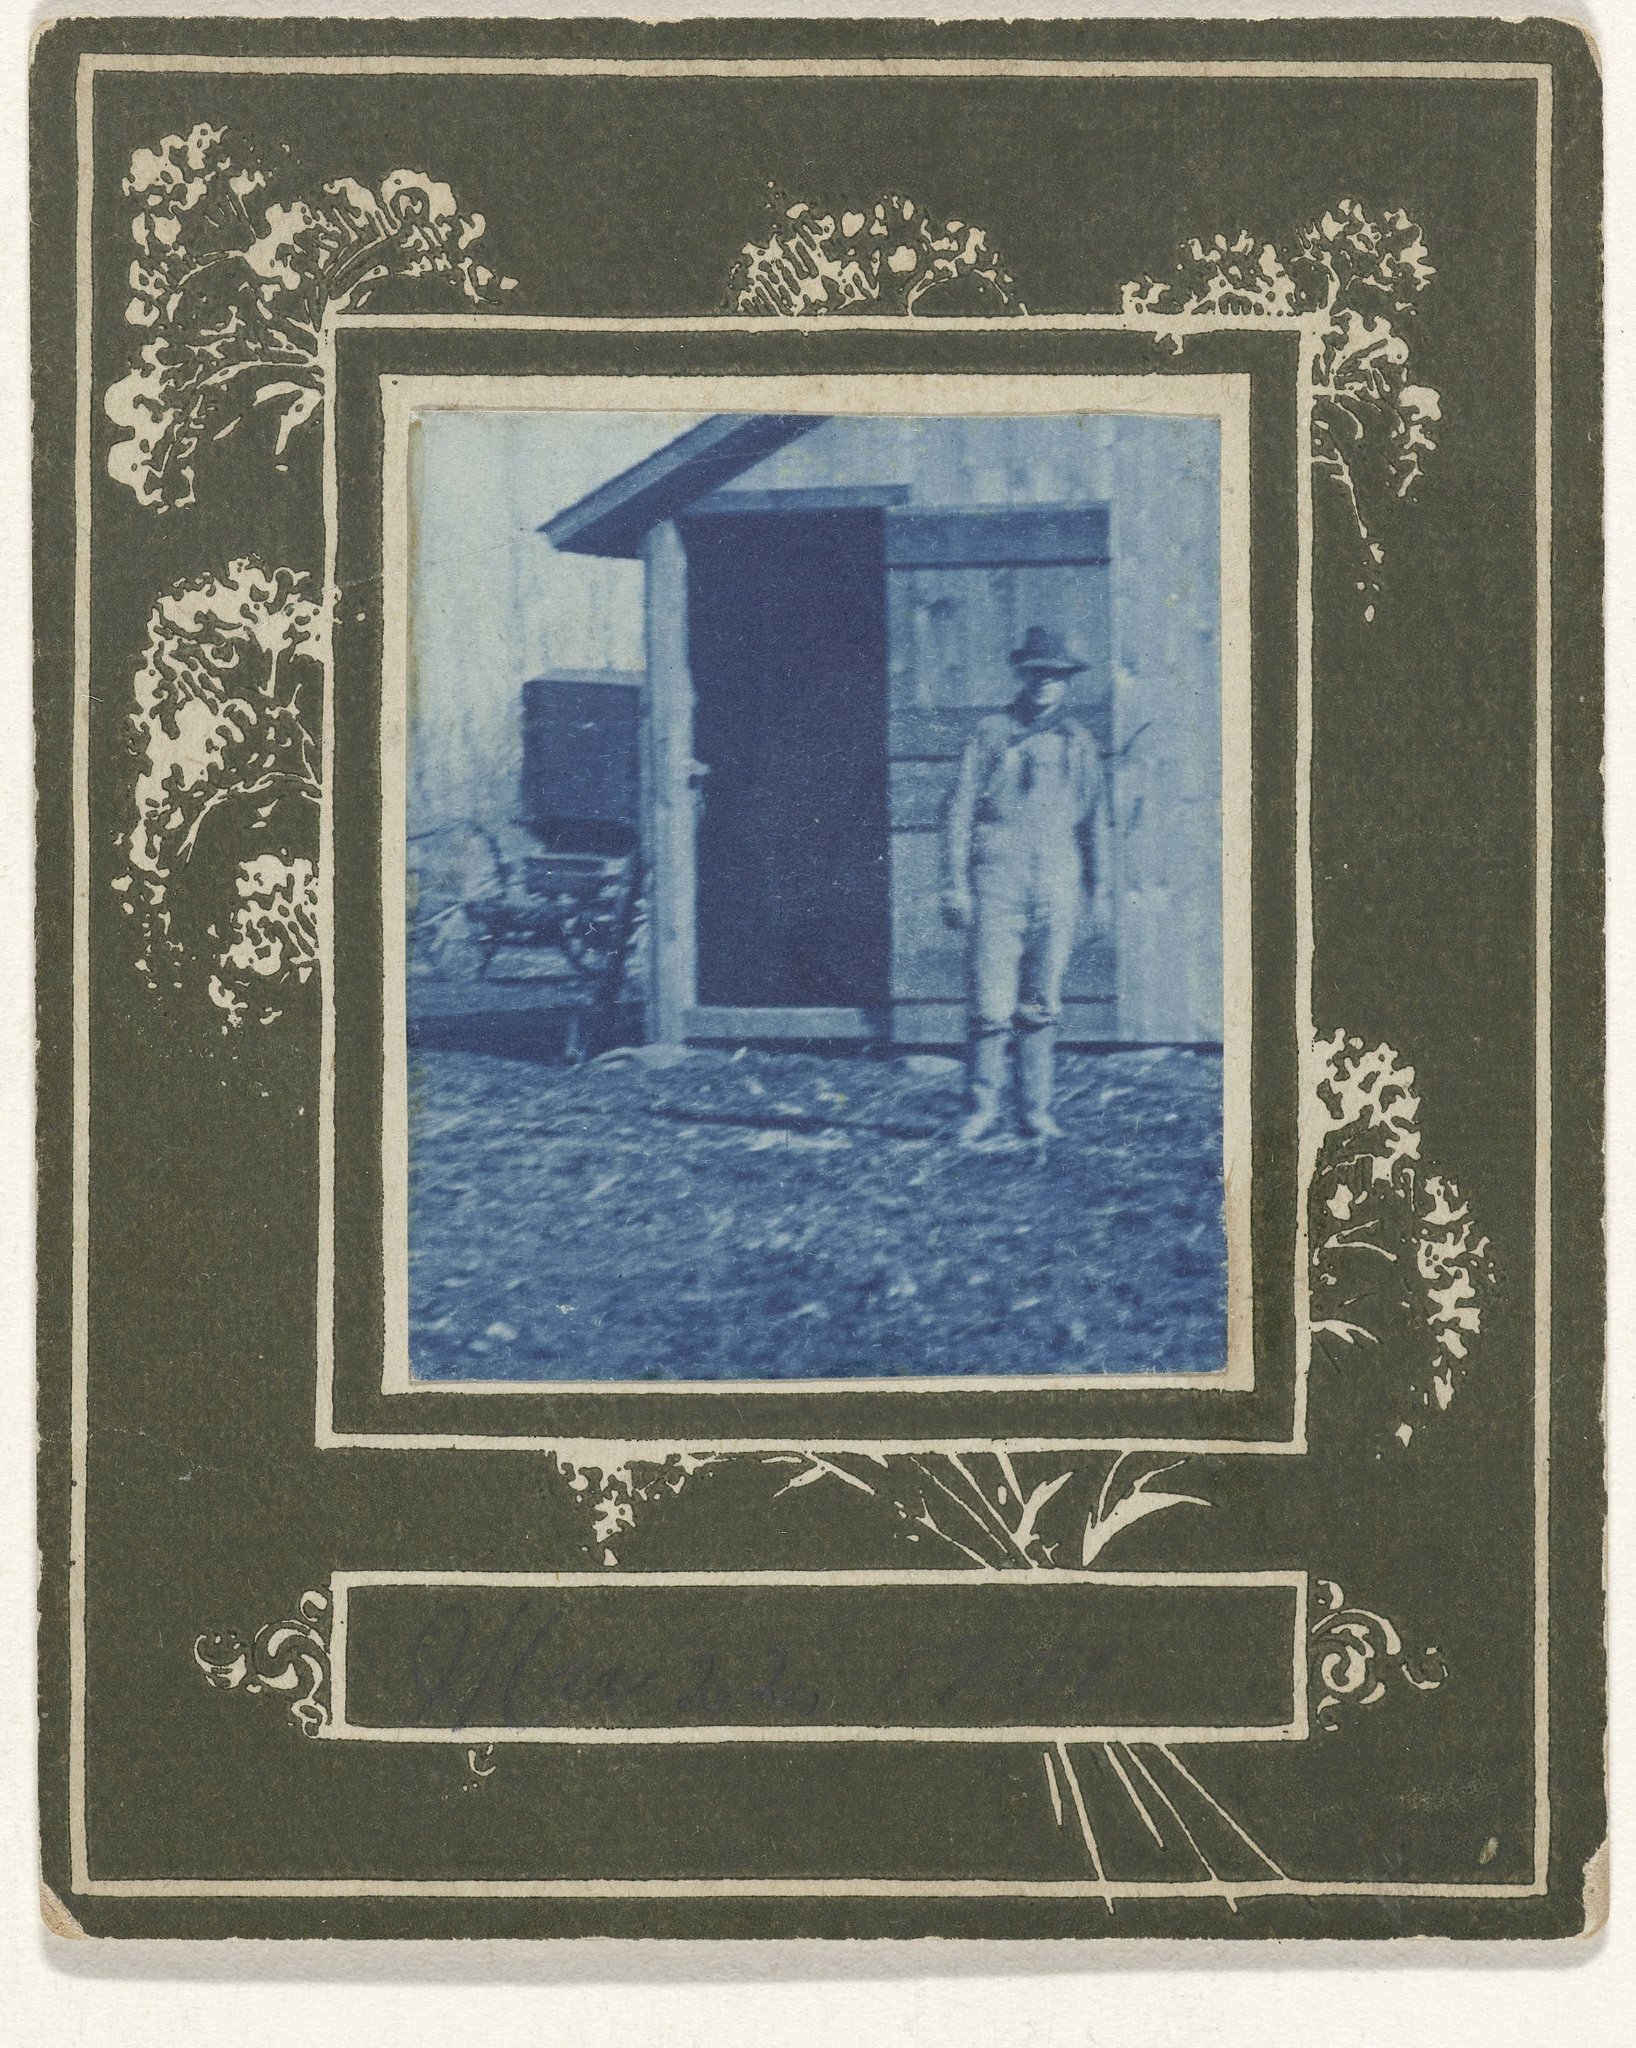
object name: photograph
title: Hall Davidson staand bij de deur van een paardenstal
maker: Anonymous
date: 1899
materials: cardboard, photographic support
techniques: cyanotype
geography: united states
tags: historical persons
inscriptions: date: ‘Mar 22, 1901’, inscription: ‘Hall [?] Davidson, by horse barn door 1899’